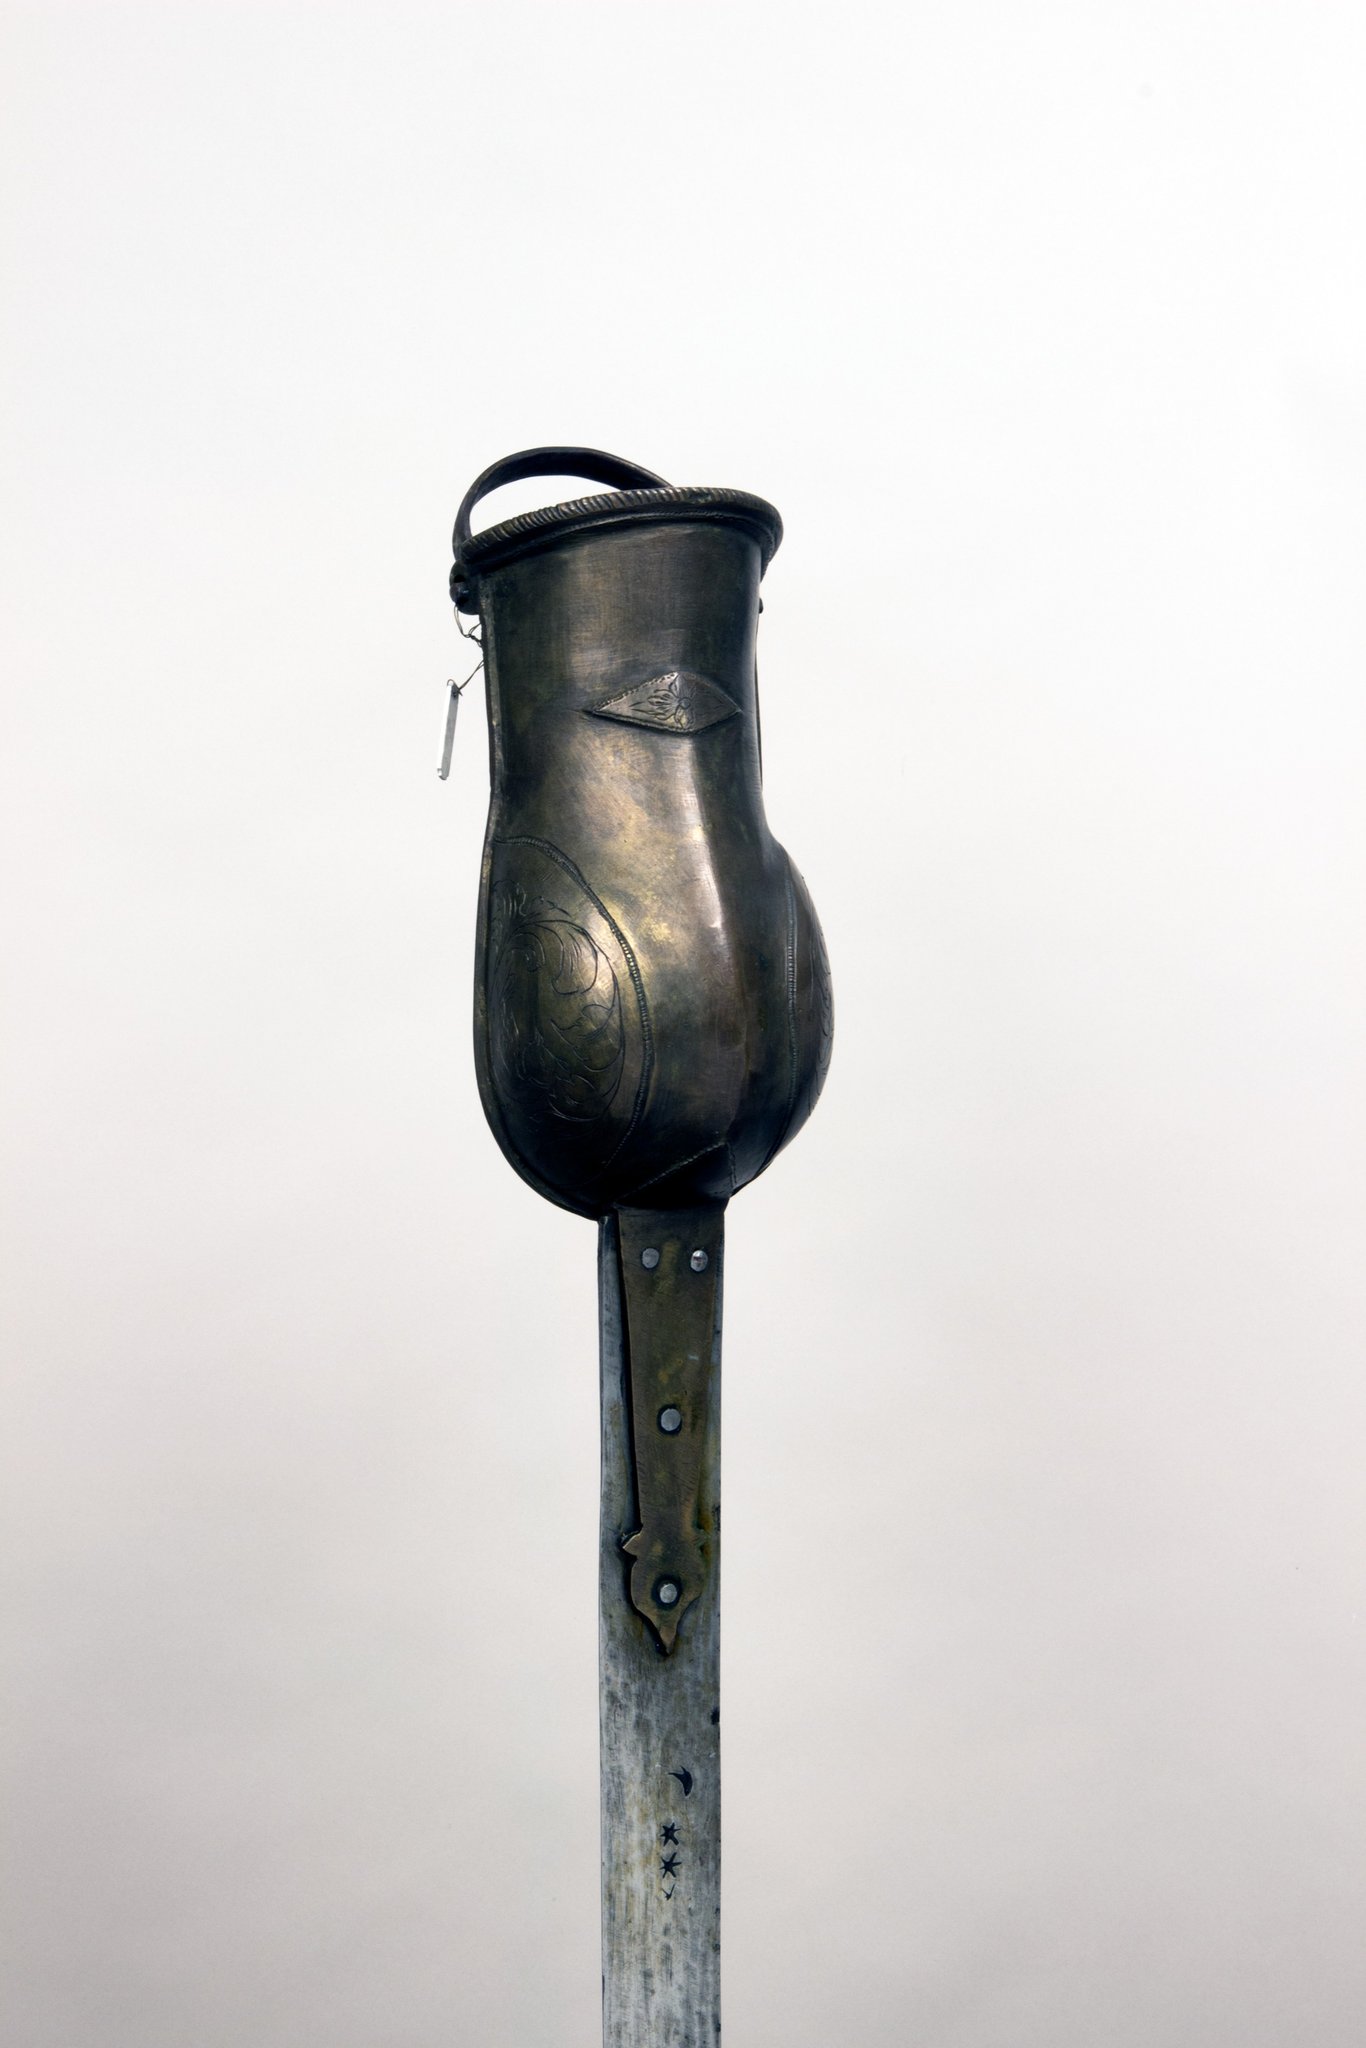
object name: gauntlet sword pata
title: Gauntlet Sword (Pata)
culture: indian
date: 1801-1900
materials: brass, steel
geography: india